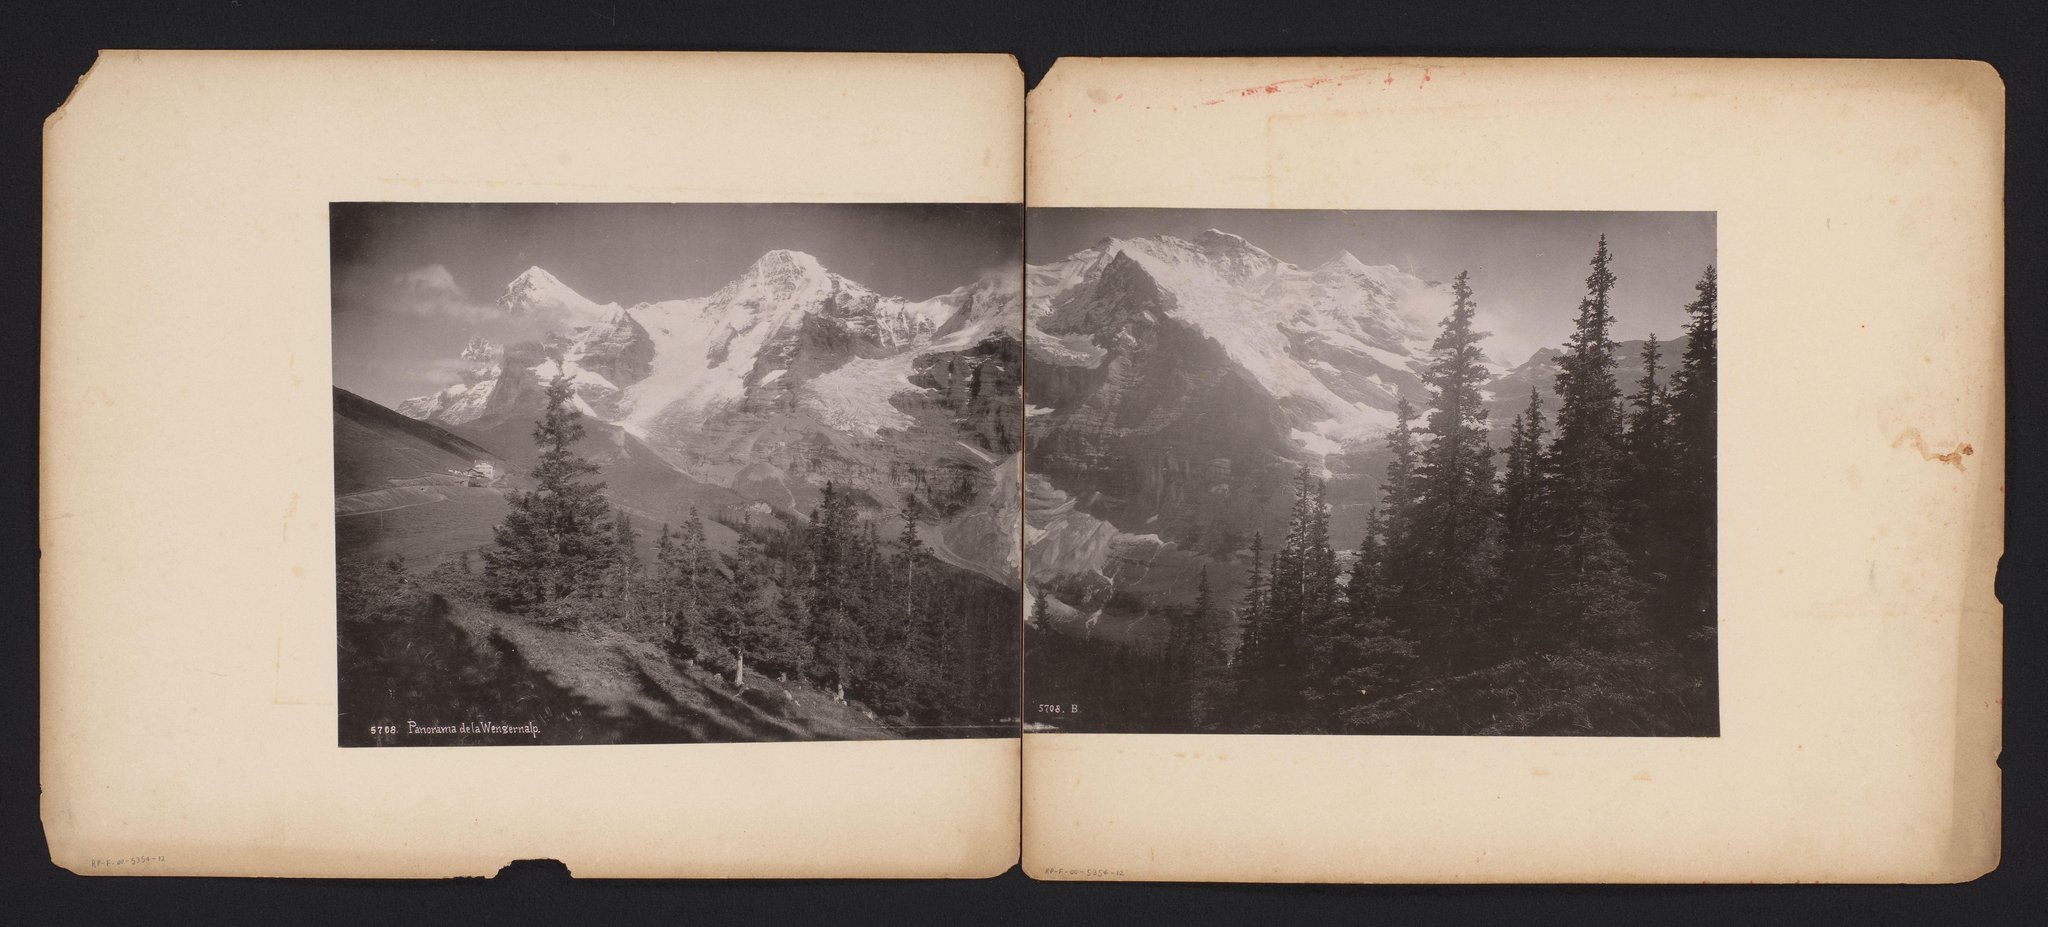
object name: photomechanical print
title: Panorama de la Wengernalp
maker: Anonymous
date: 1890-1910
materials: cardboard, paper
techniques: photograph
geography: wengernalp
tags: mountains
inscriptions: inscription: ‘5708. Panorama de la Wengernalp’, inscription: ‘5708 B.’, inscription: ‘14 00’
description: Deze fotomechanische afdruk maakt deel uit van een omslag.